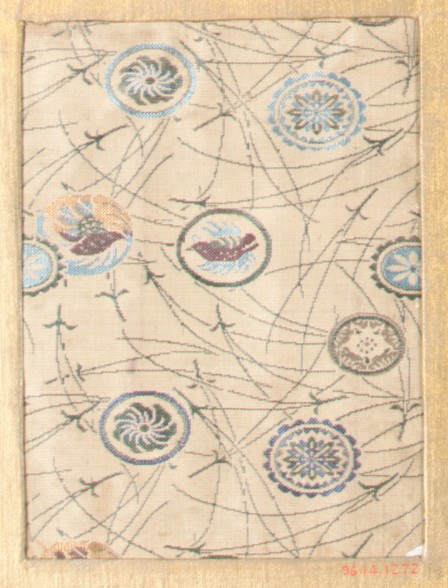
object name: piece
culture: japanese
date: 1701-1900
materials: silk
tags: birds